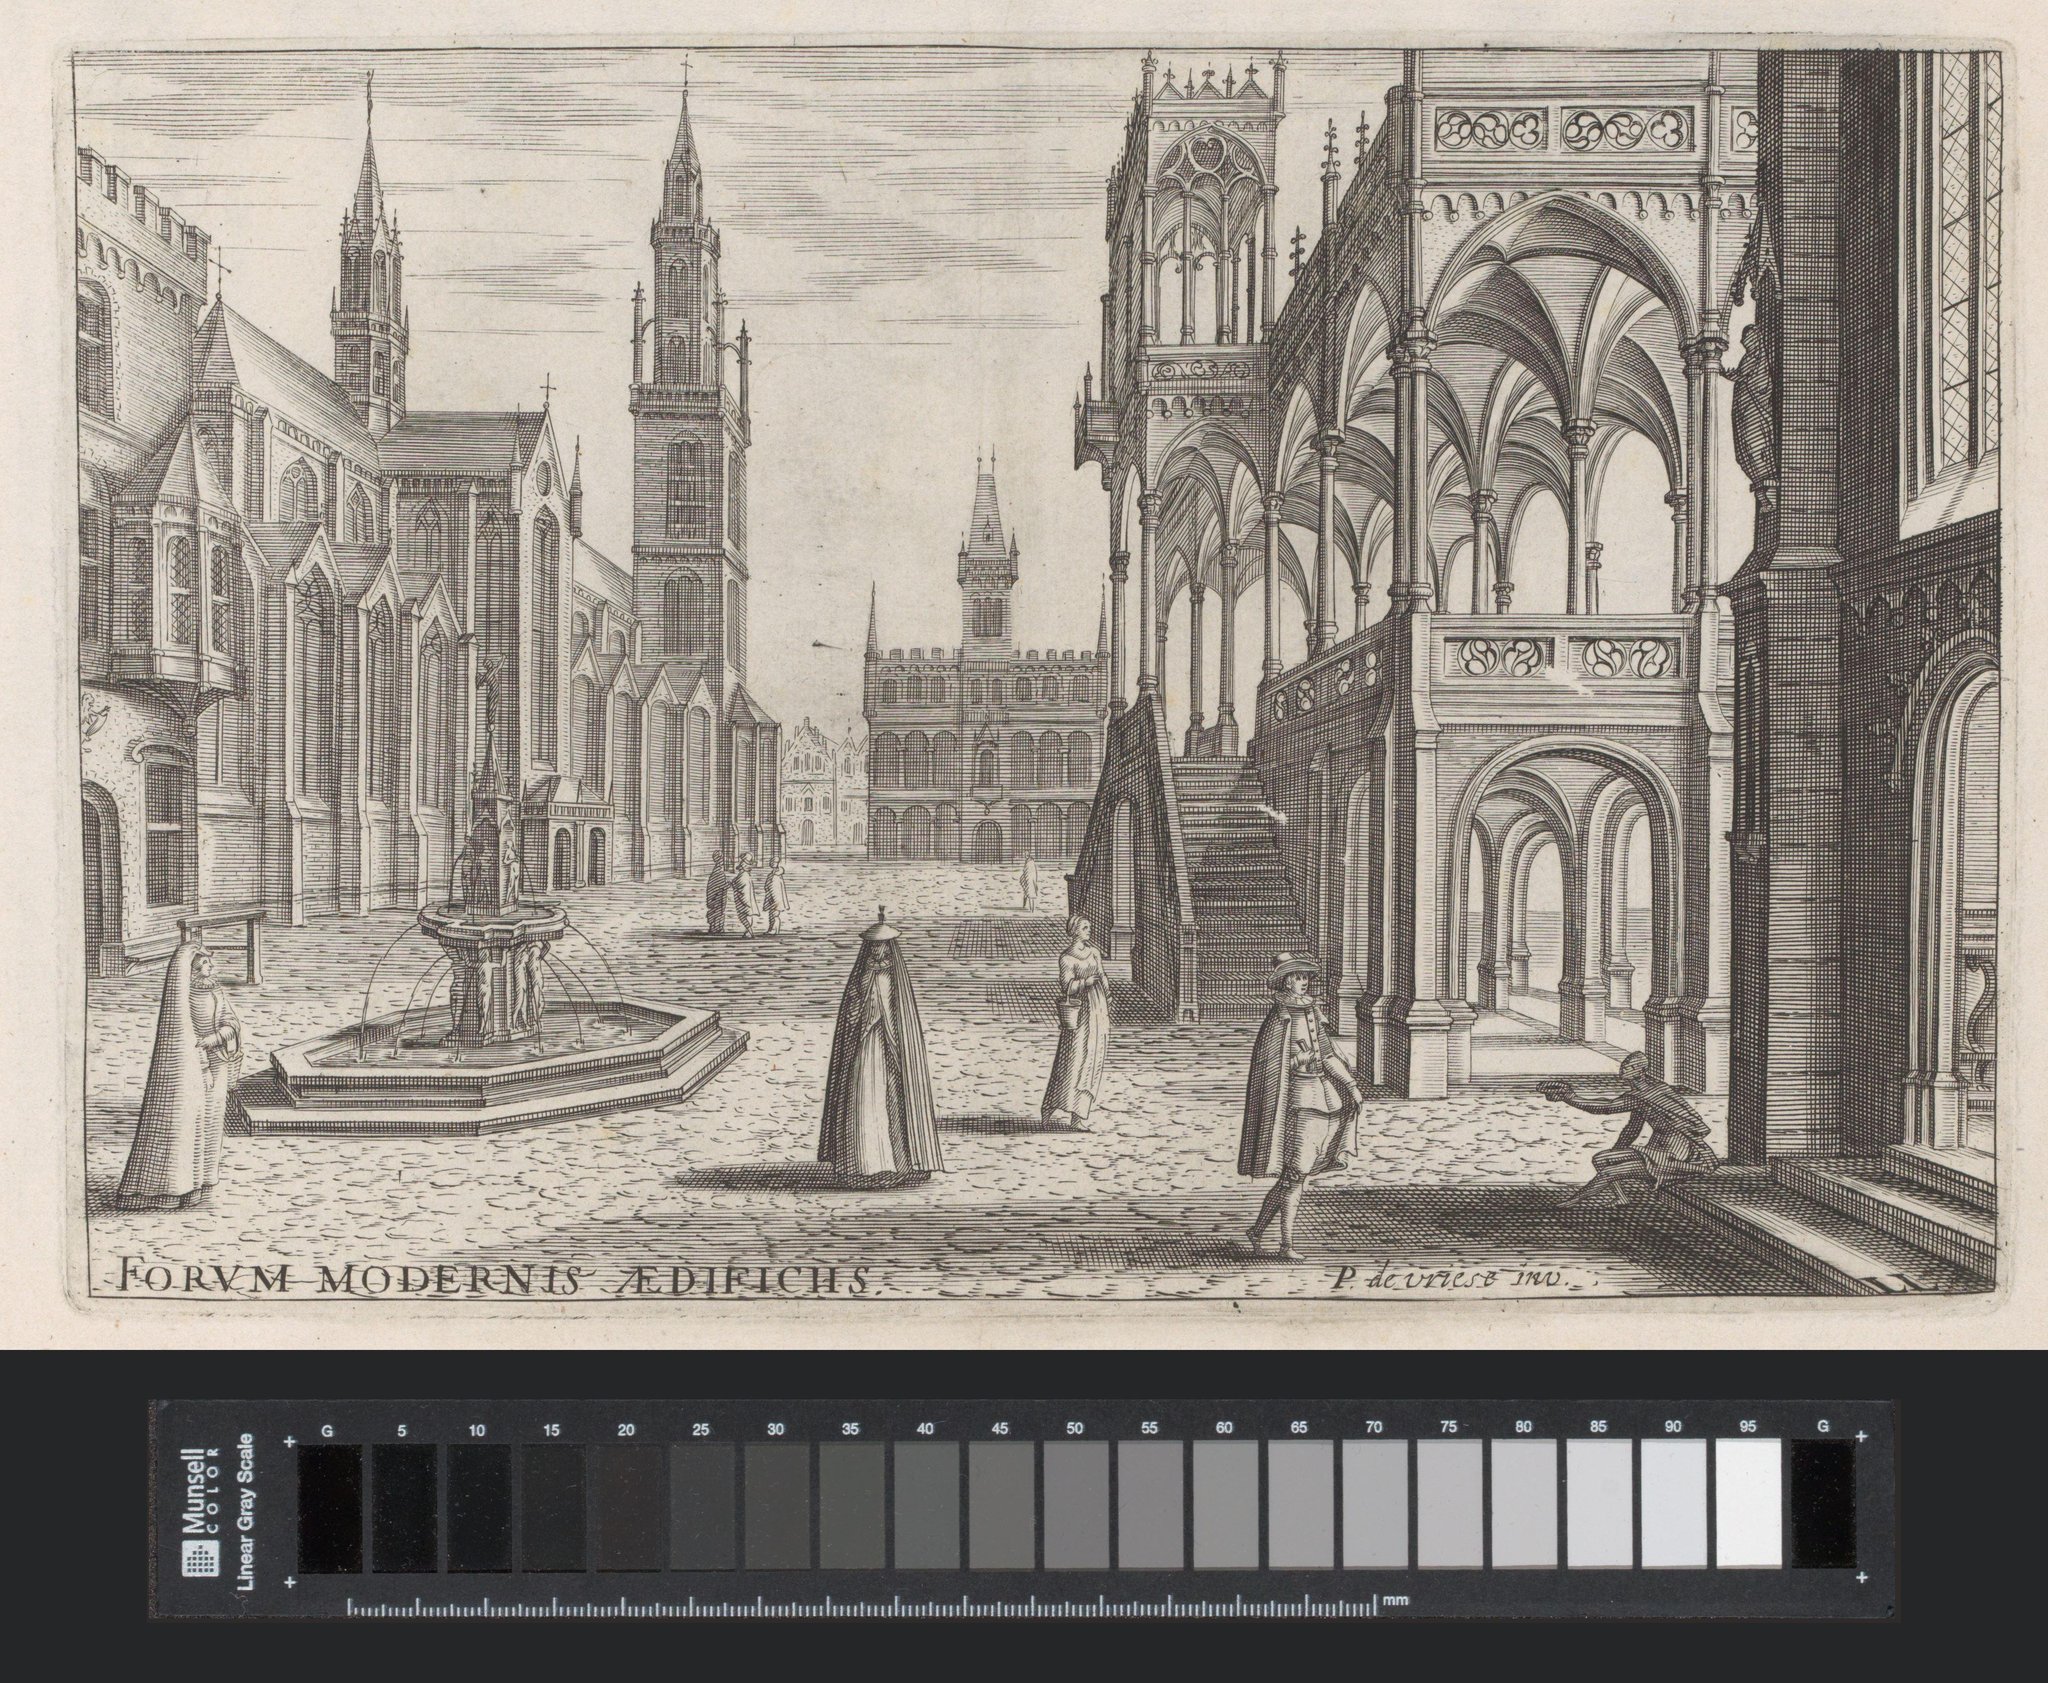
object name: album leaf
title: Forum Modernis Aedifichs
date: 1606-1607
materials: paper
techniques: engraving, etching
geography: amsterdam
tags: ornamental fountain (in village), village square, place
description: Stadsplein met links een kerk, rechts een gebouw met zuilenportaal en in het midden een fontein. Verschillende figuren lopen op het plein. Rechtsonder: LL. Prent maakt deel uit van een album.